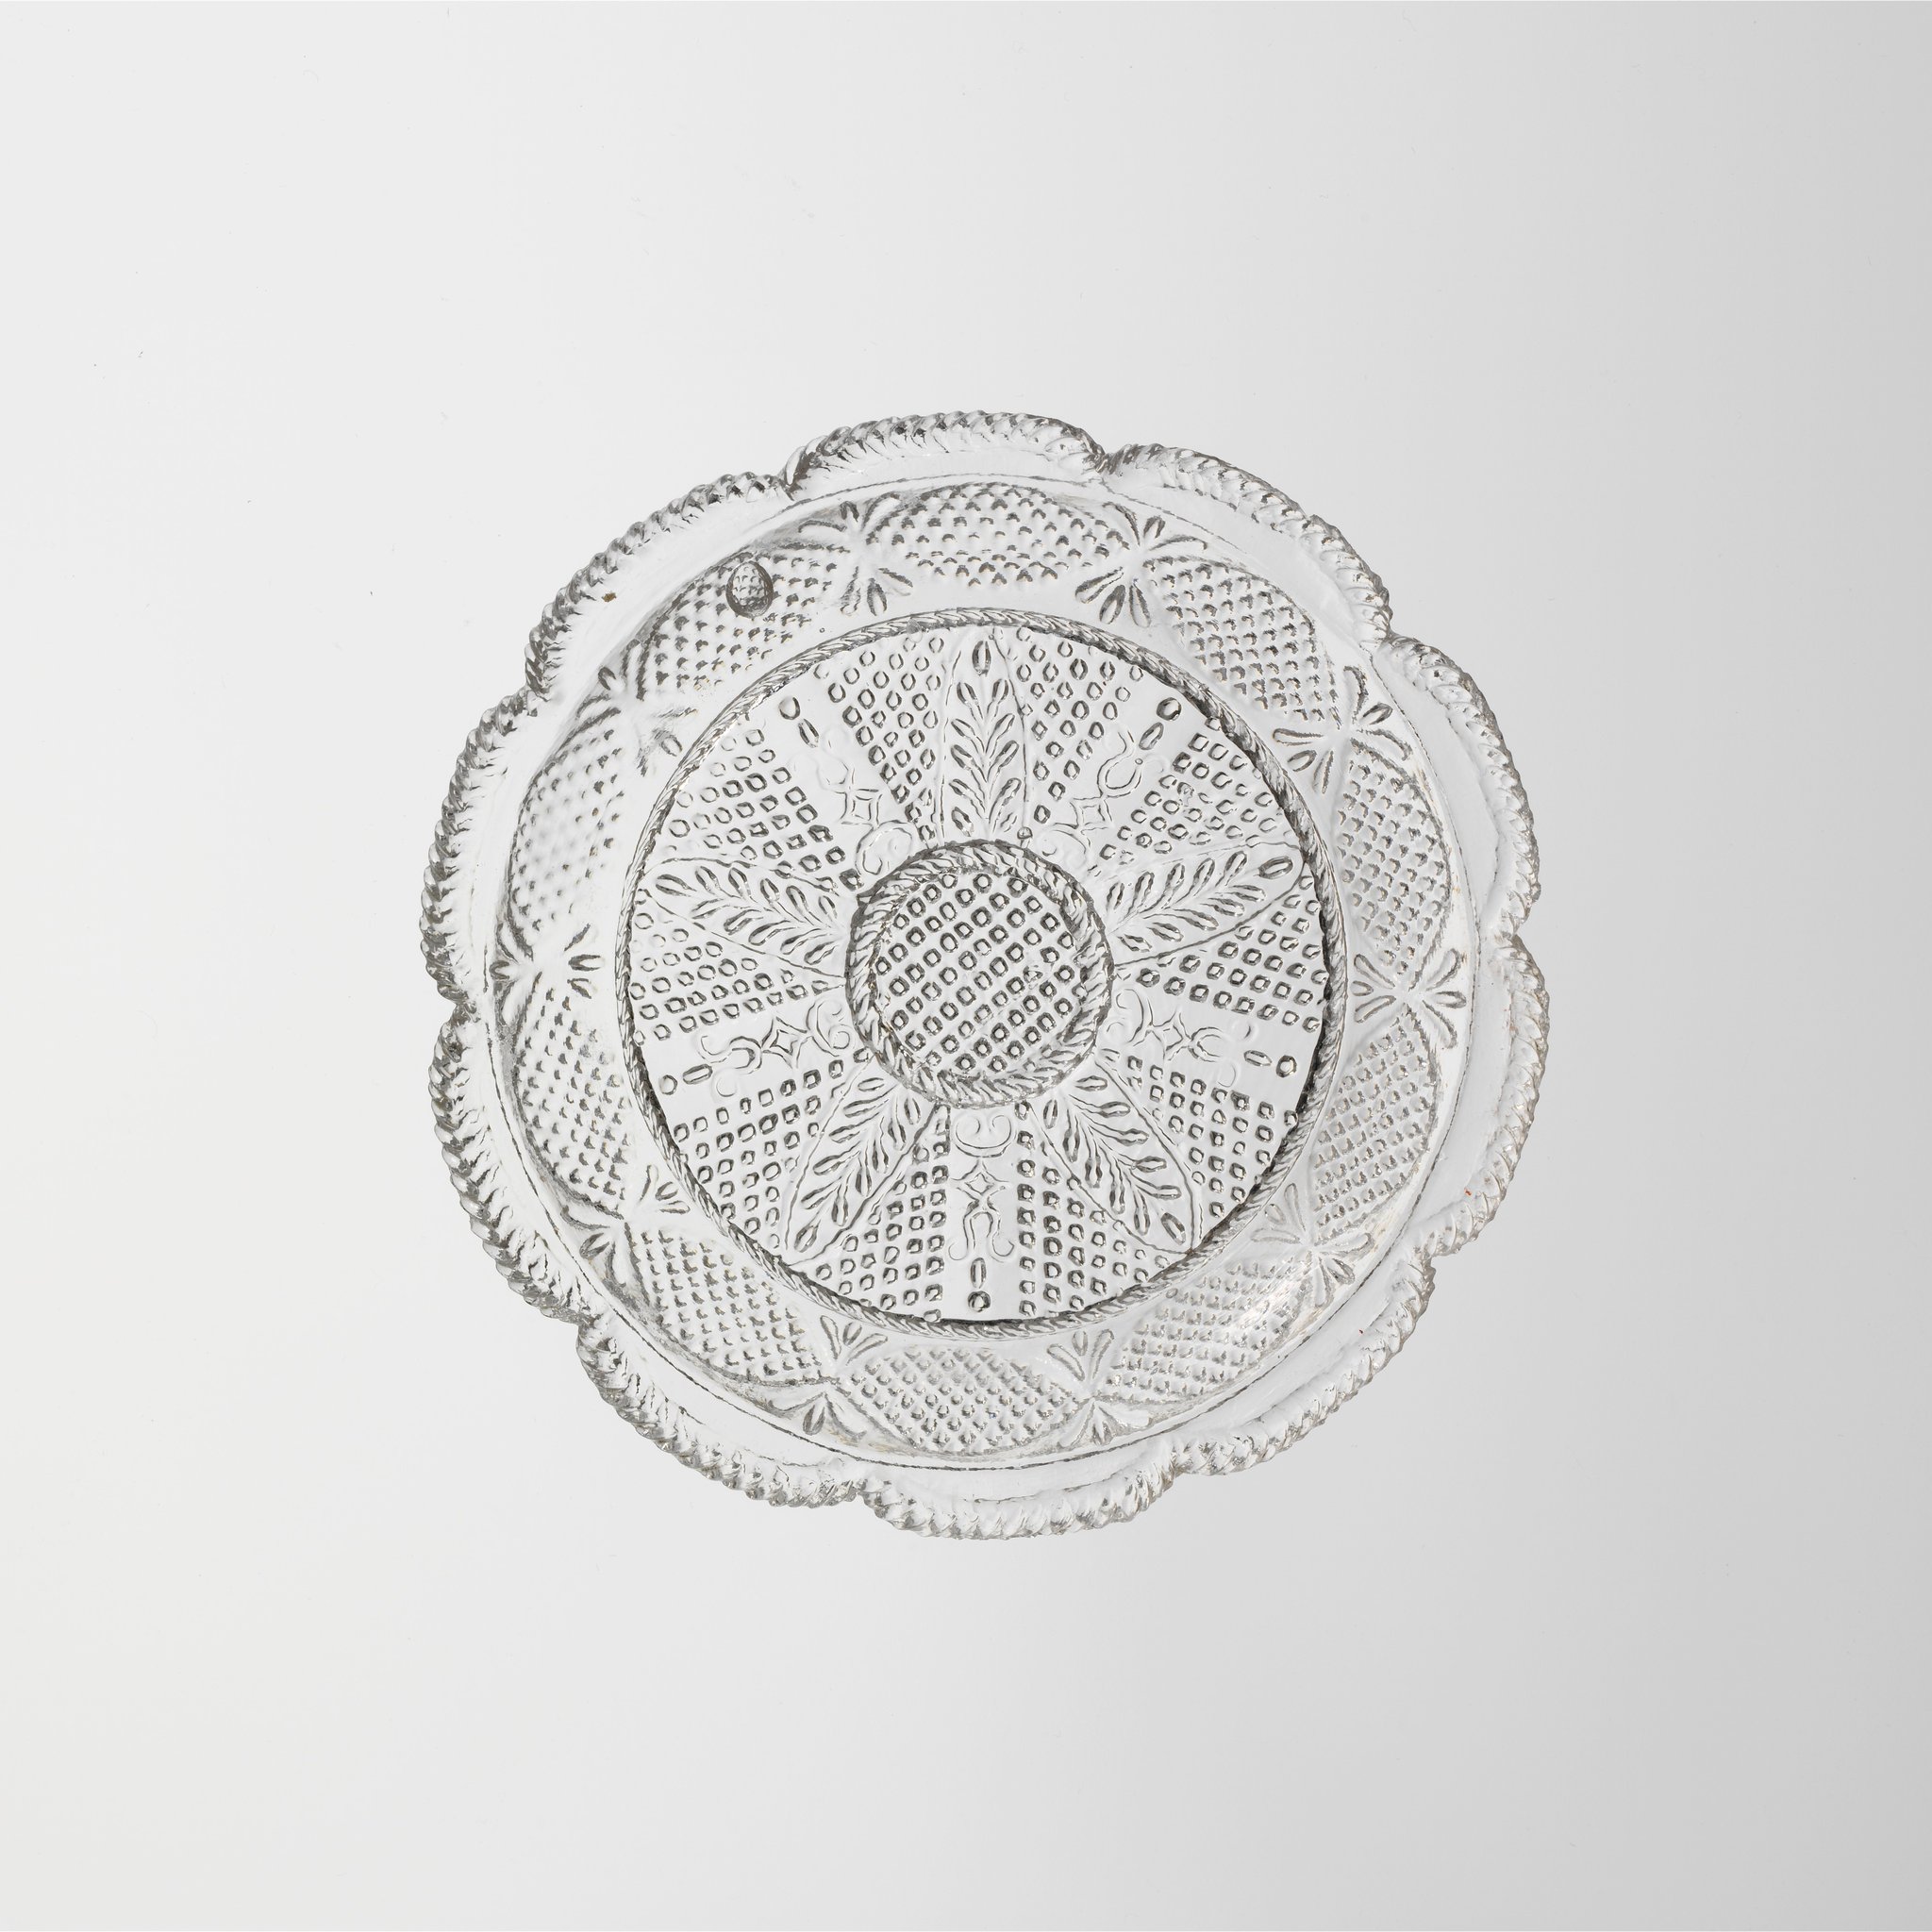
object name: cup plate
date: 1825-1860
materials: glass